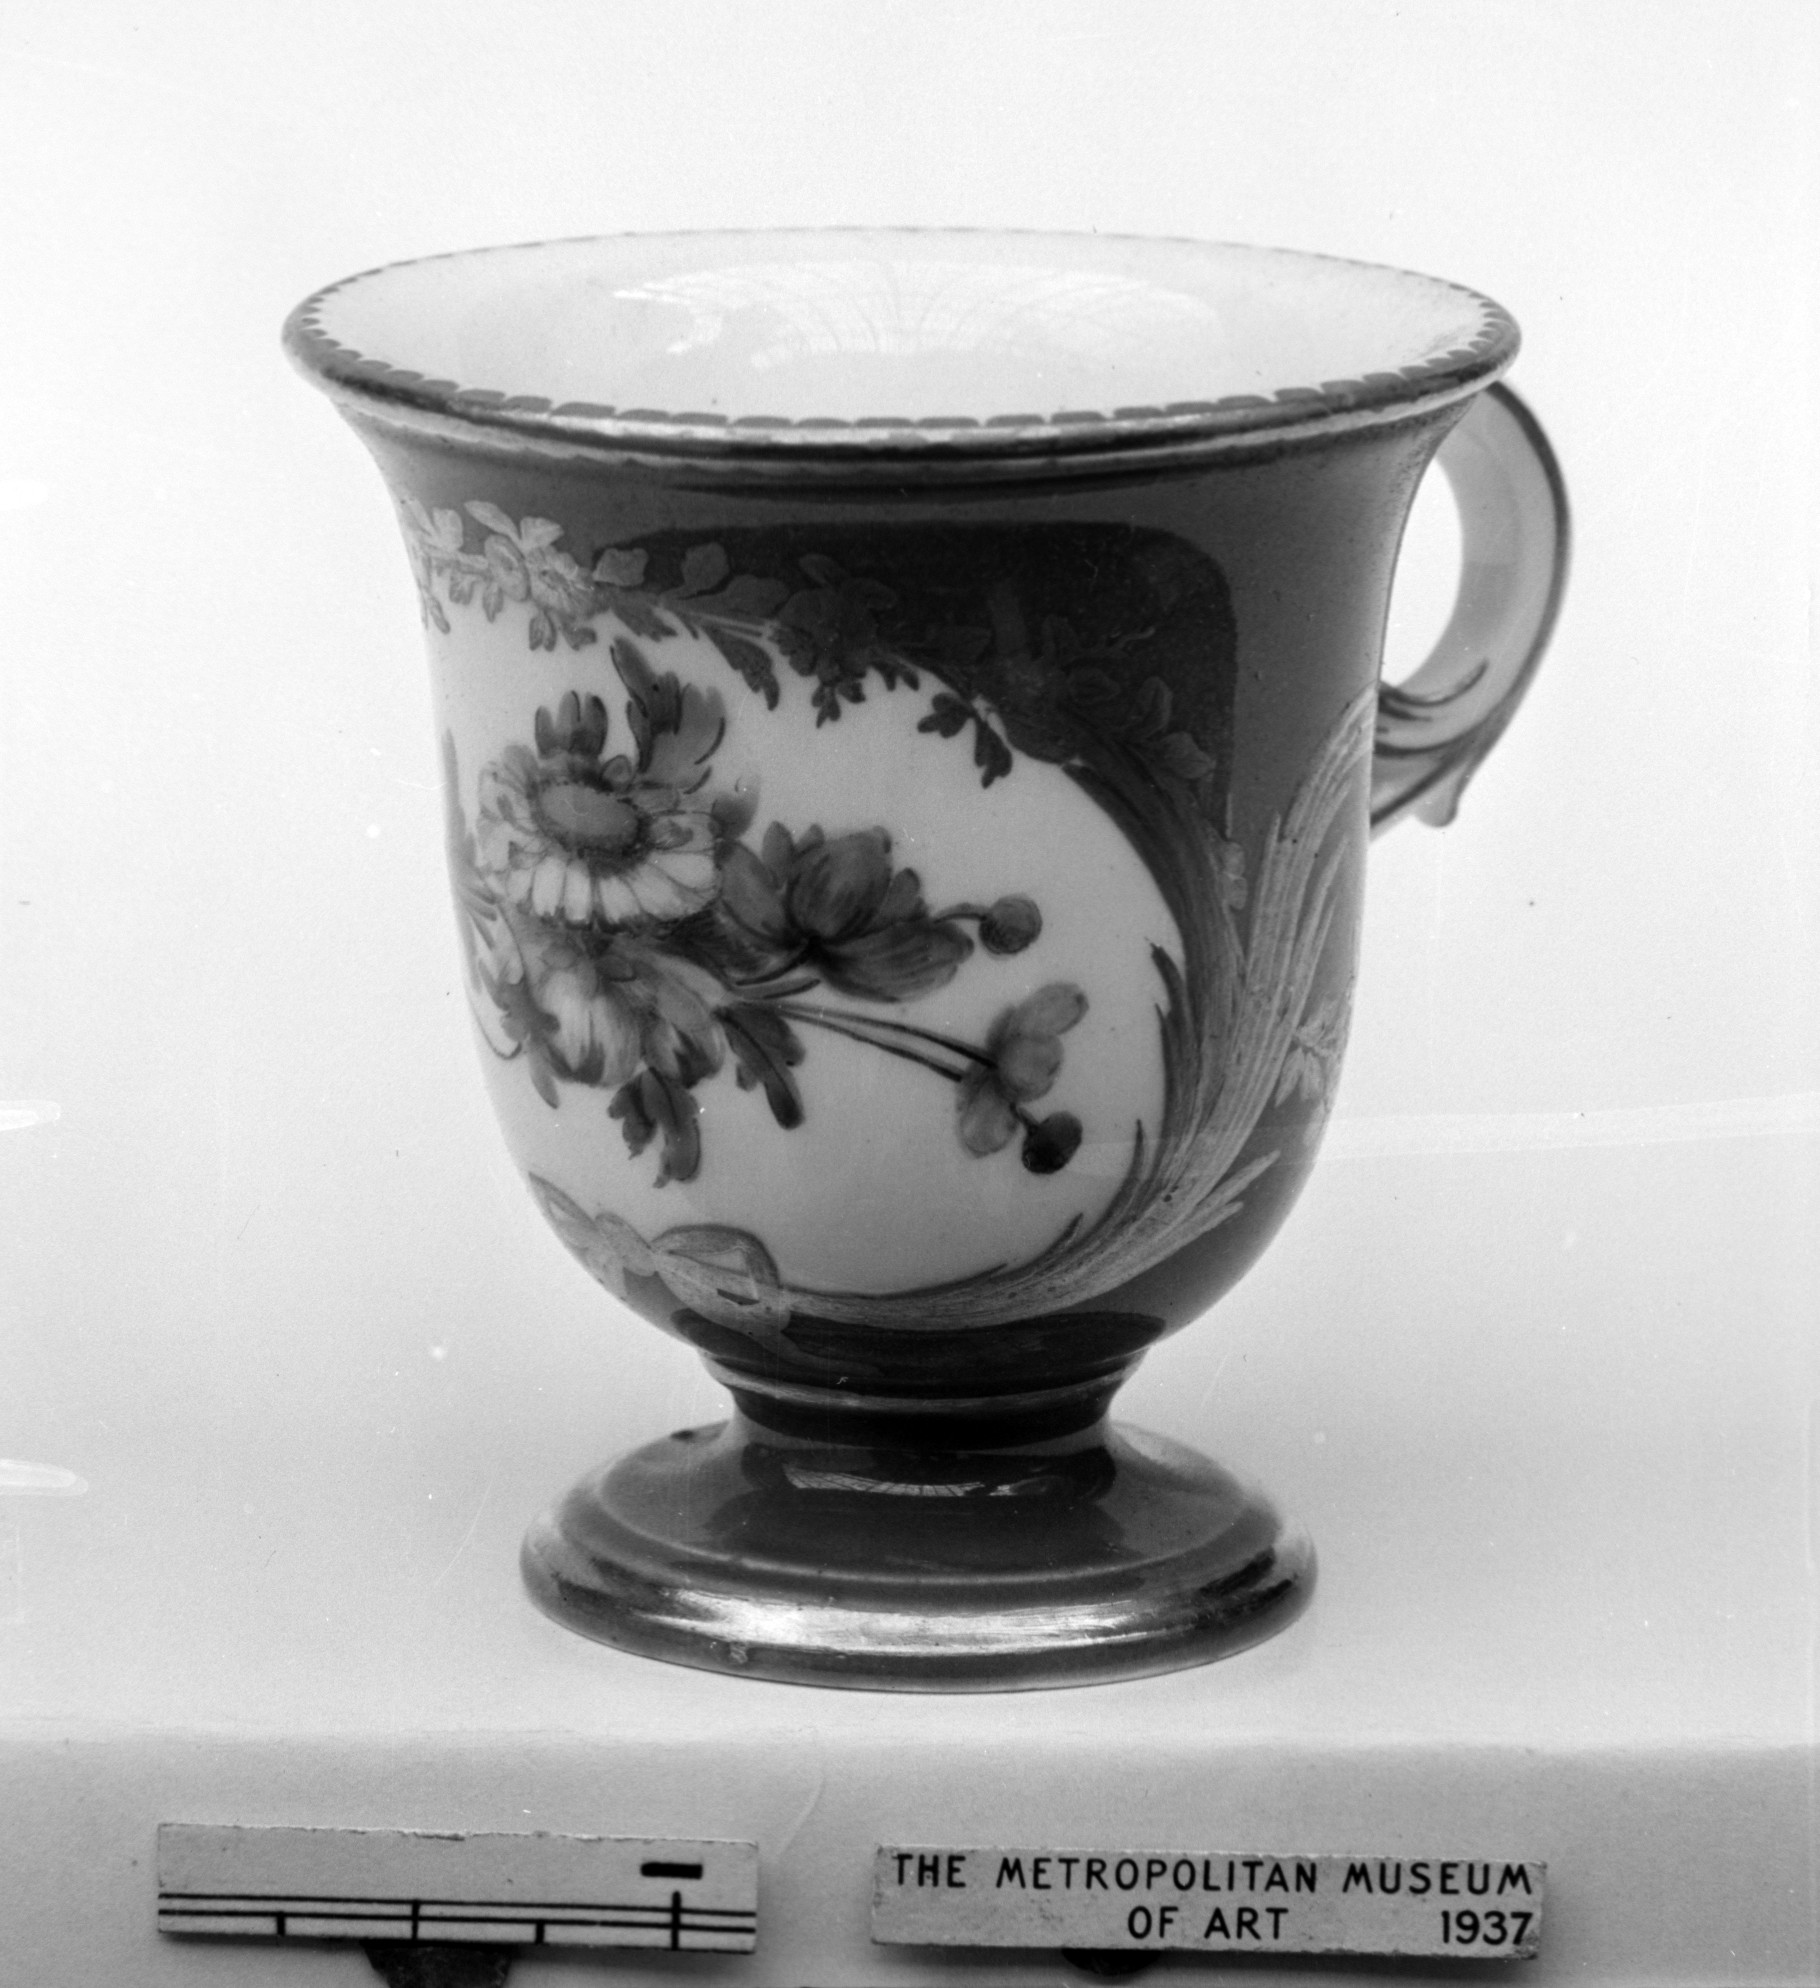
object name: ice cream cup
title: Ice cream cup (Tasse à glace) (part of a service)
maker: sèvres manufactory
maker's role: manufactory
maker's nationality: french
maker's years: 1740-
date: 1780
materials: soft paste porcelain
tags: flowers